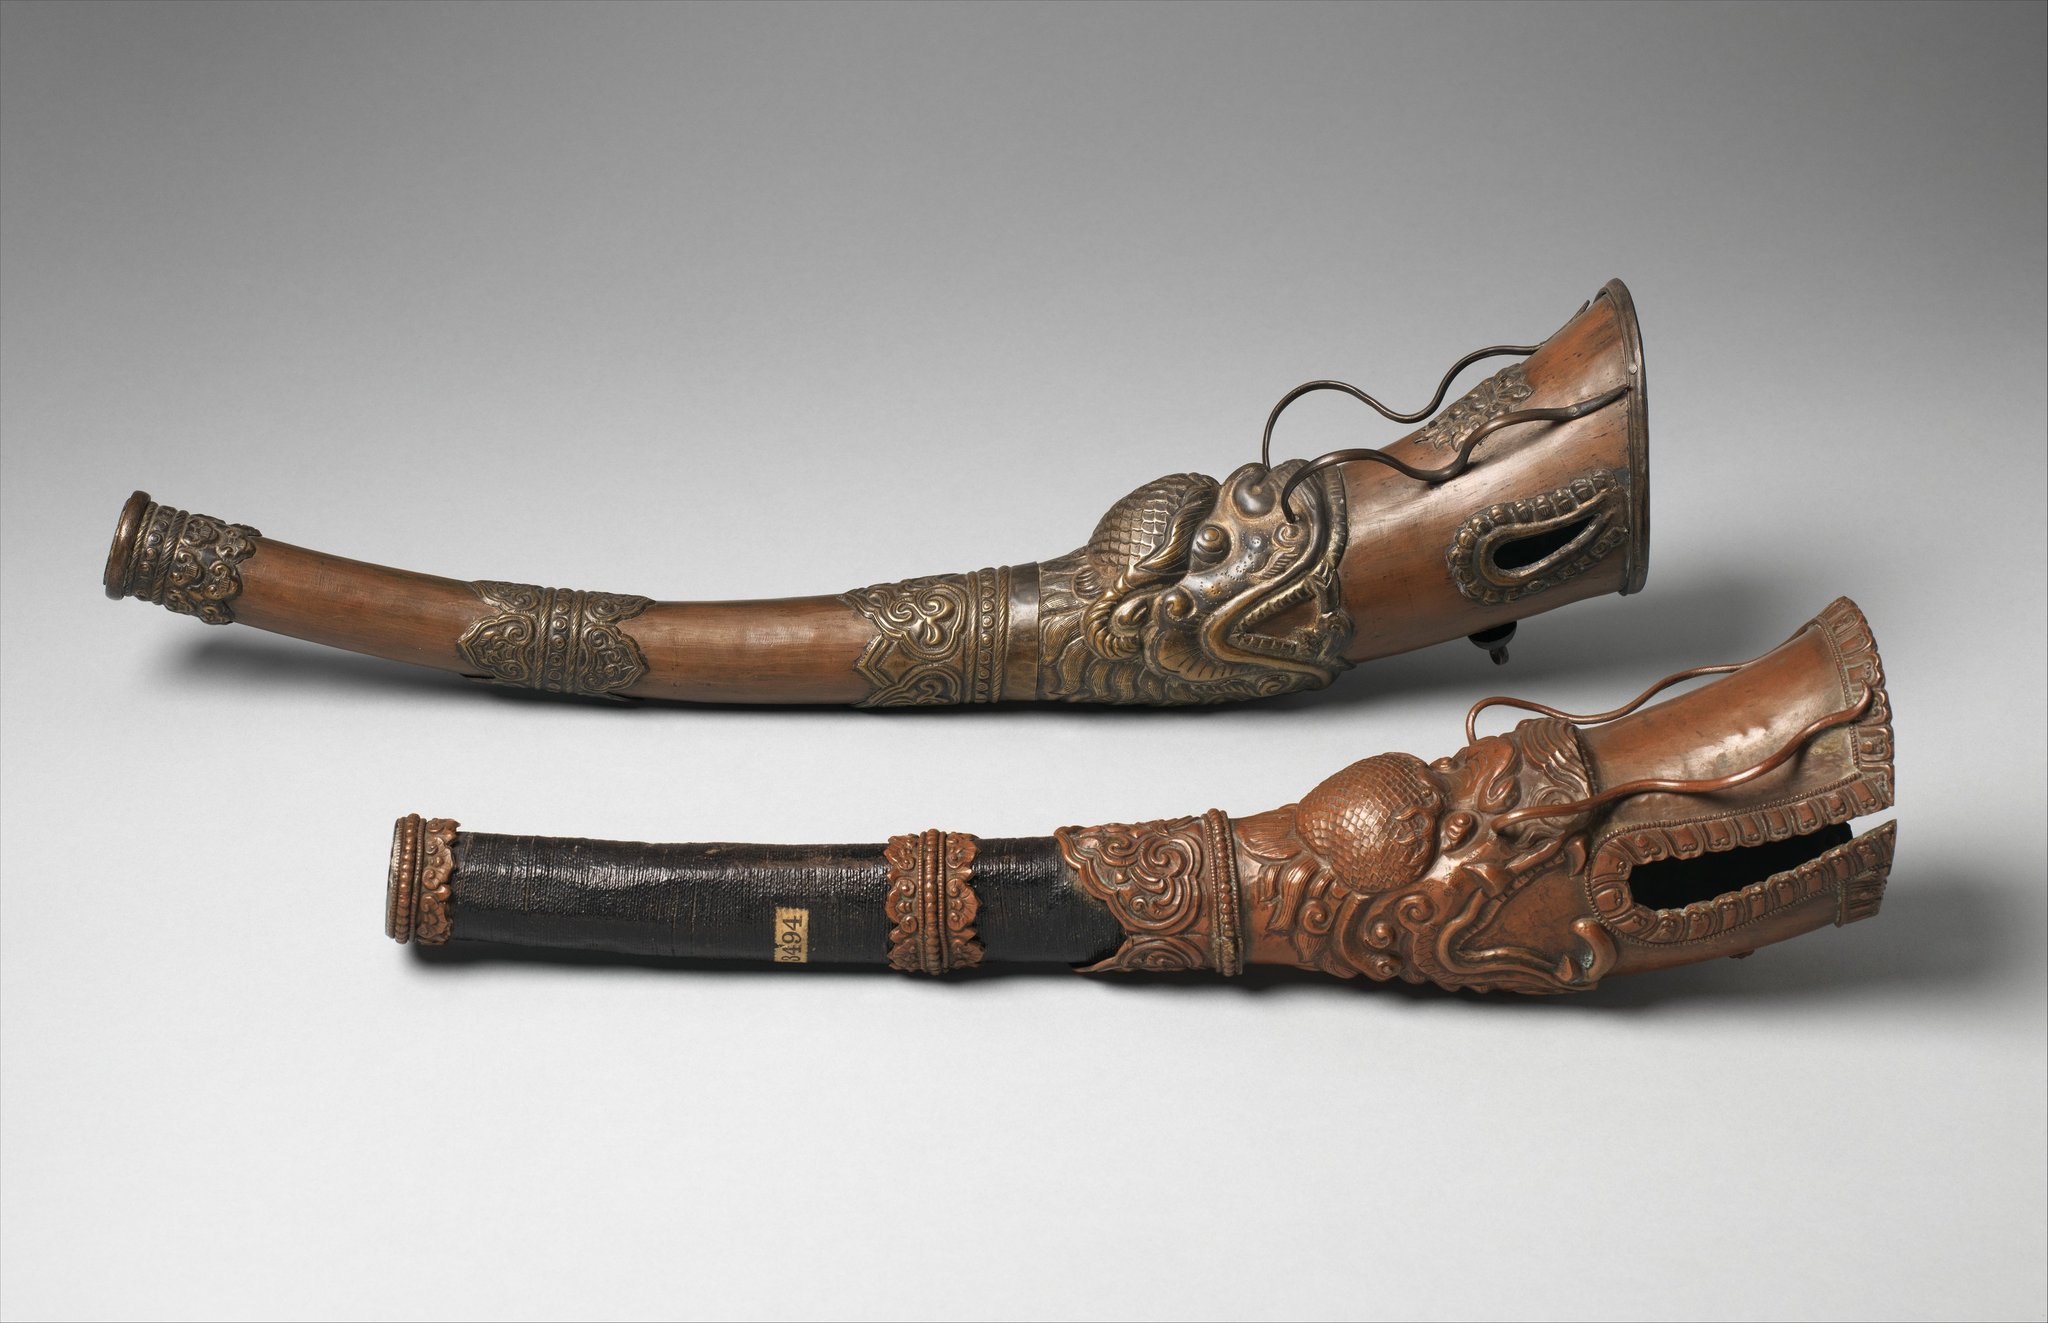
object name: rkangling leg bone flute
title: Rkangling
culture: tibetan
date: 1867-1900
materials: copper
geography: tibet